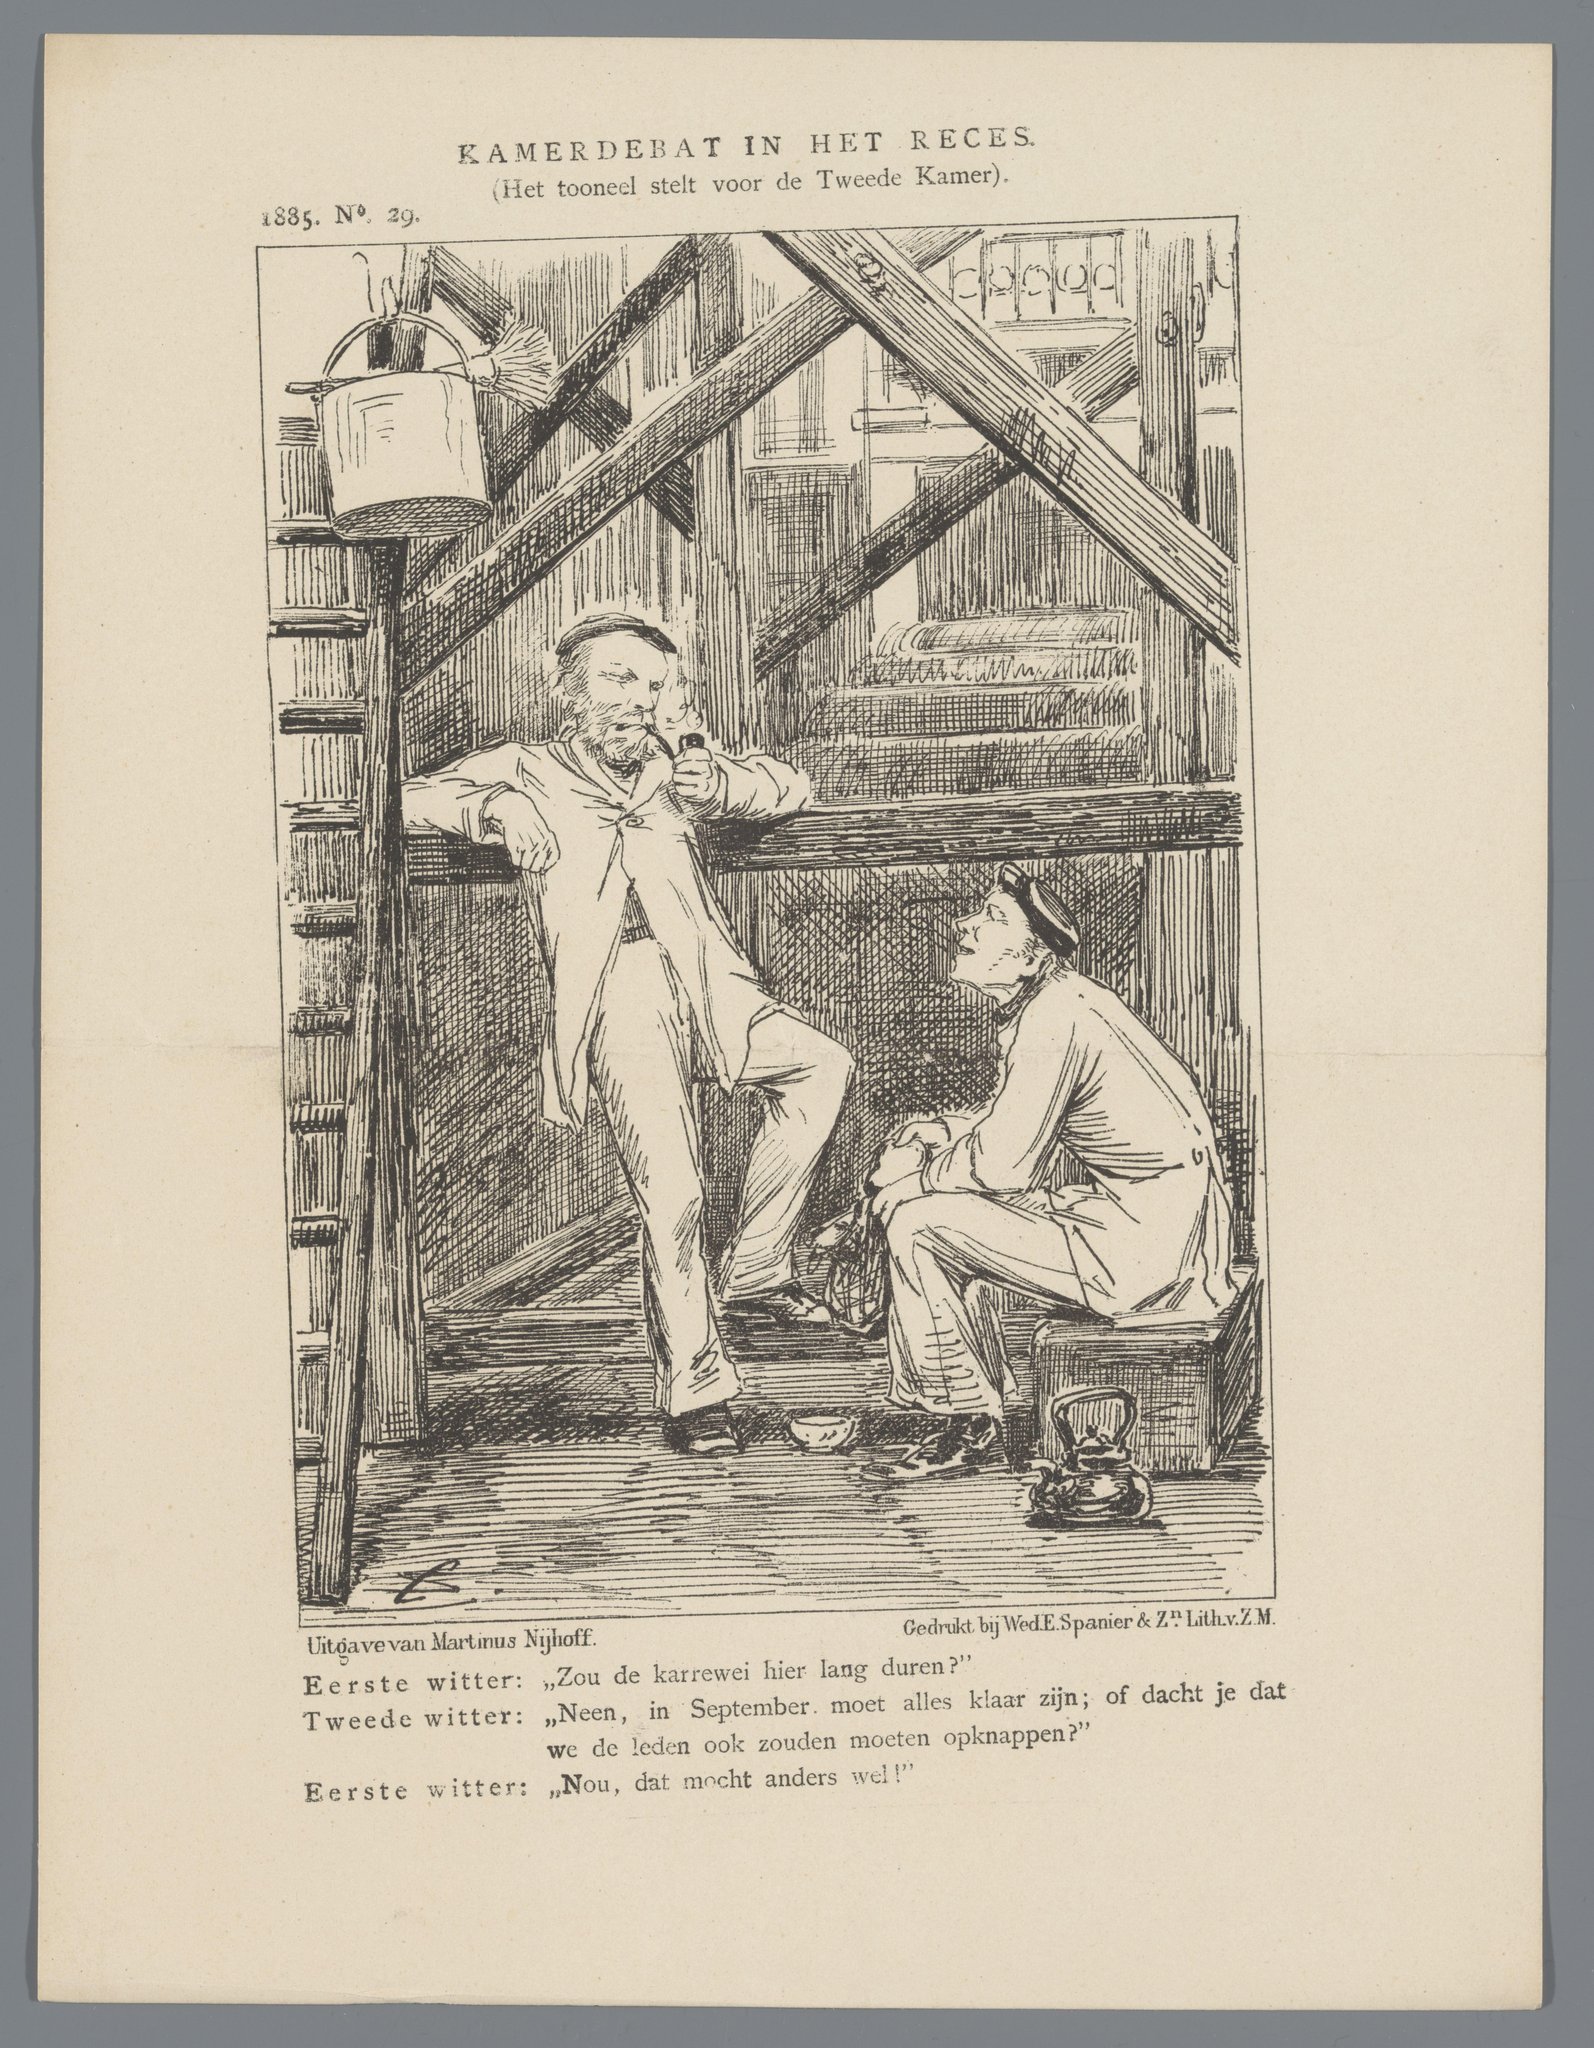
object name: cartoon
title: Spotprent op de kamerdebatten gehouden tijdes het reces, 1885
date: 1885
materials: paper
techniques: lithograph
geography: netherlands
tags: tweede kamer der staten-generaal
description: Spotprent op de kamerdebatten gehouden tijdes het reces (tijdens bouwwerkzaamheden in de Tweede Kamer). Plaat verschenen bij het weekblad De Nederlandsche Spectator, nr. 29, 1885.